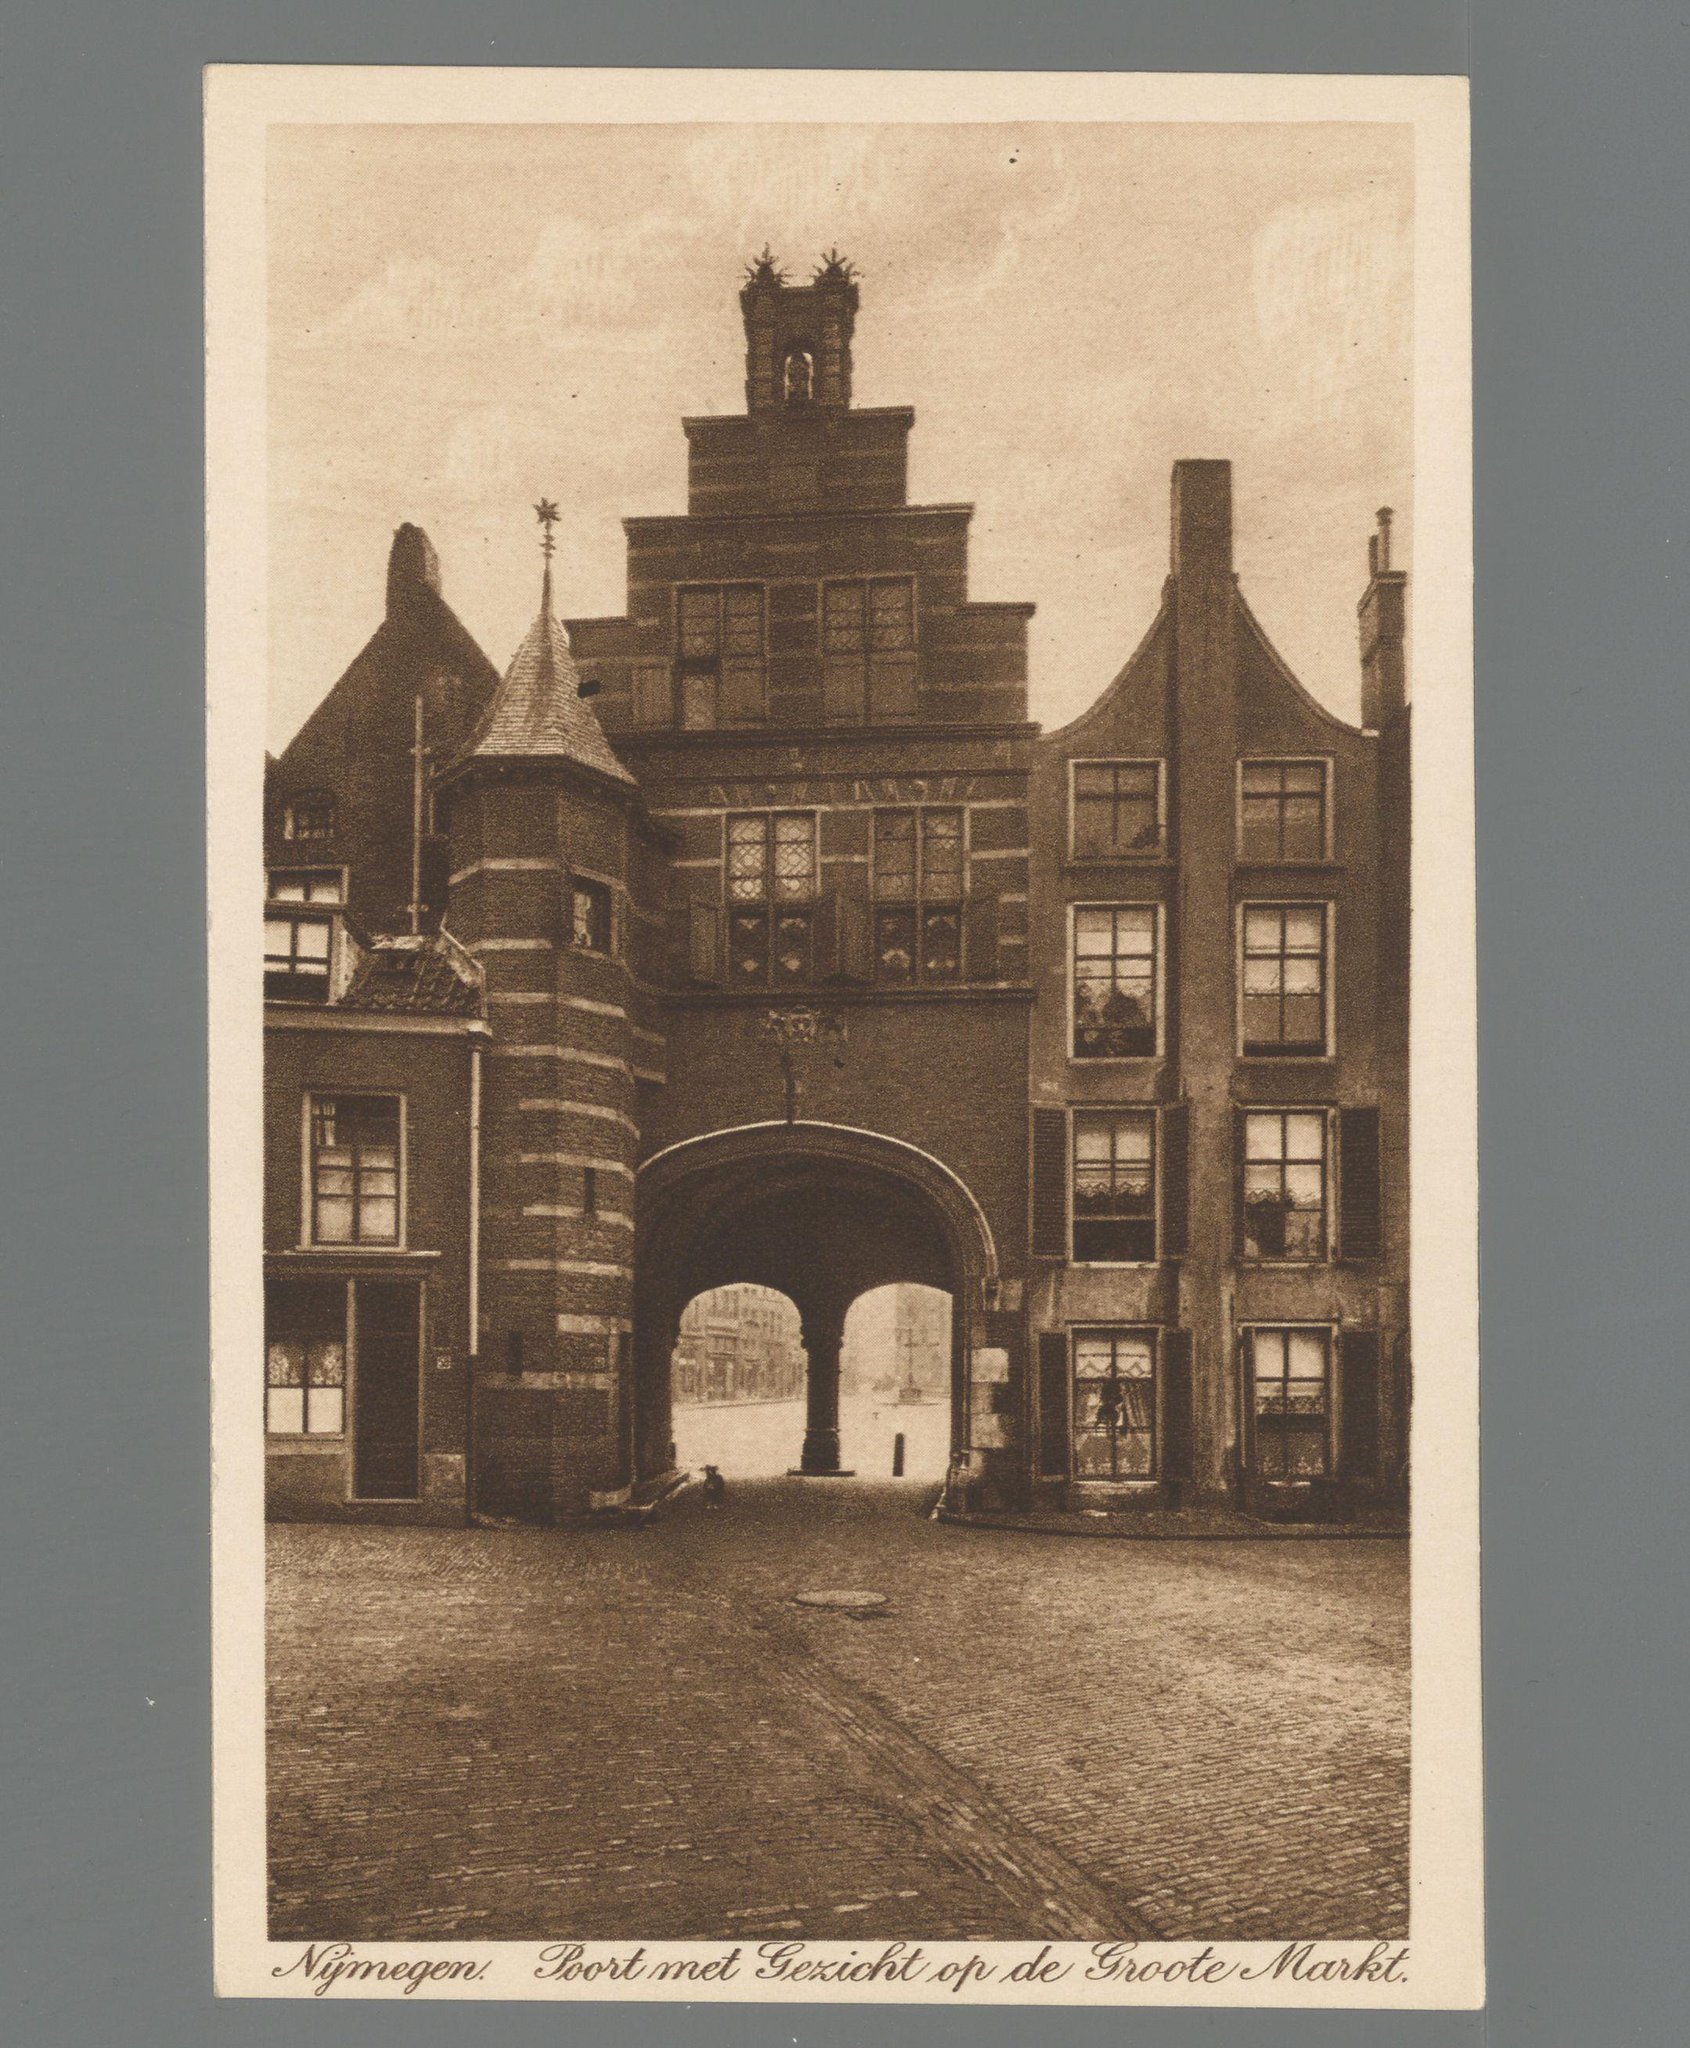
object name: ansichtkaart, prentbriefkaart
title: Nijmegen. Poort met gezicht op de Groote Markt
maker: Anonymous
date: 1916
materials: cardboard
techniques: rotogravure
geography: the hague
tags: square, place, circus, etc., city-gate, nijmegen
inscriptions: date